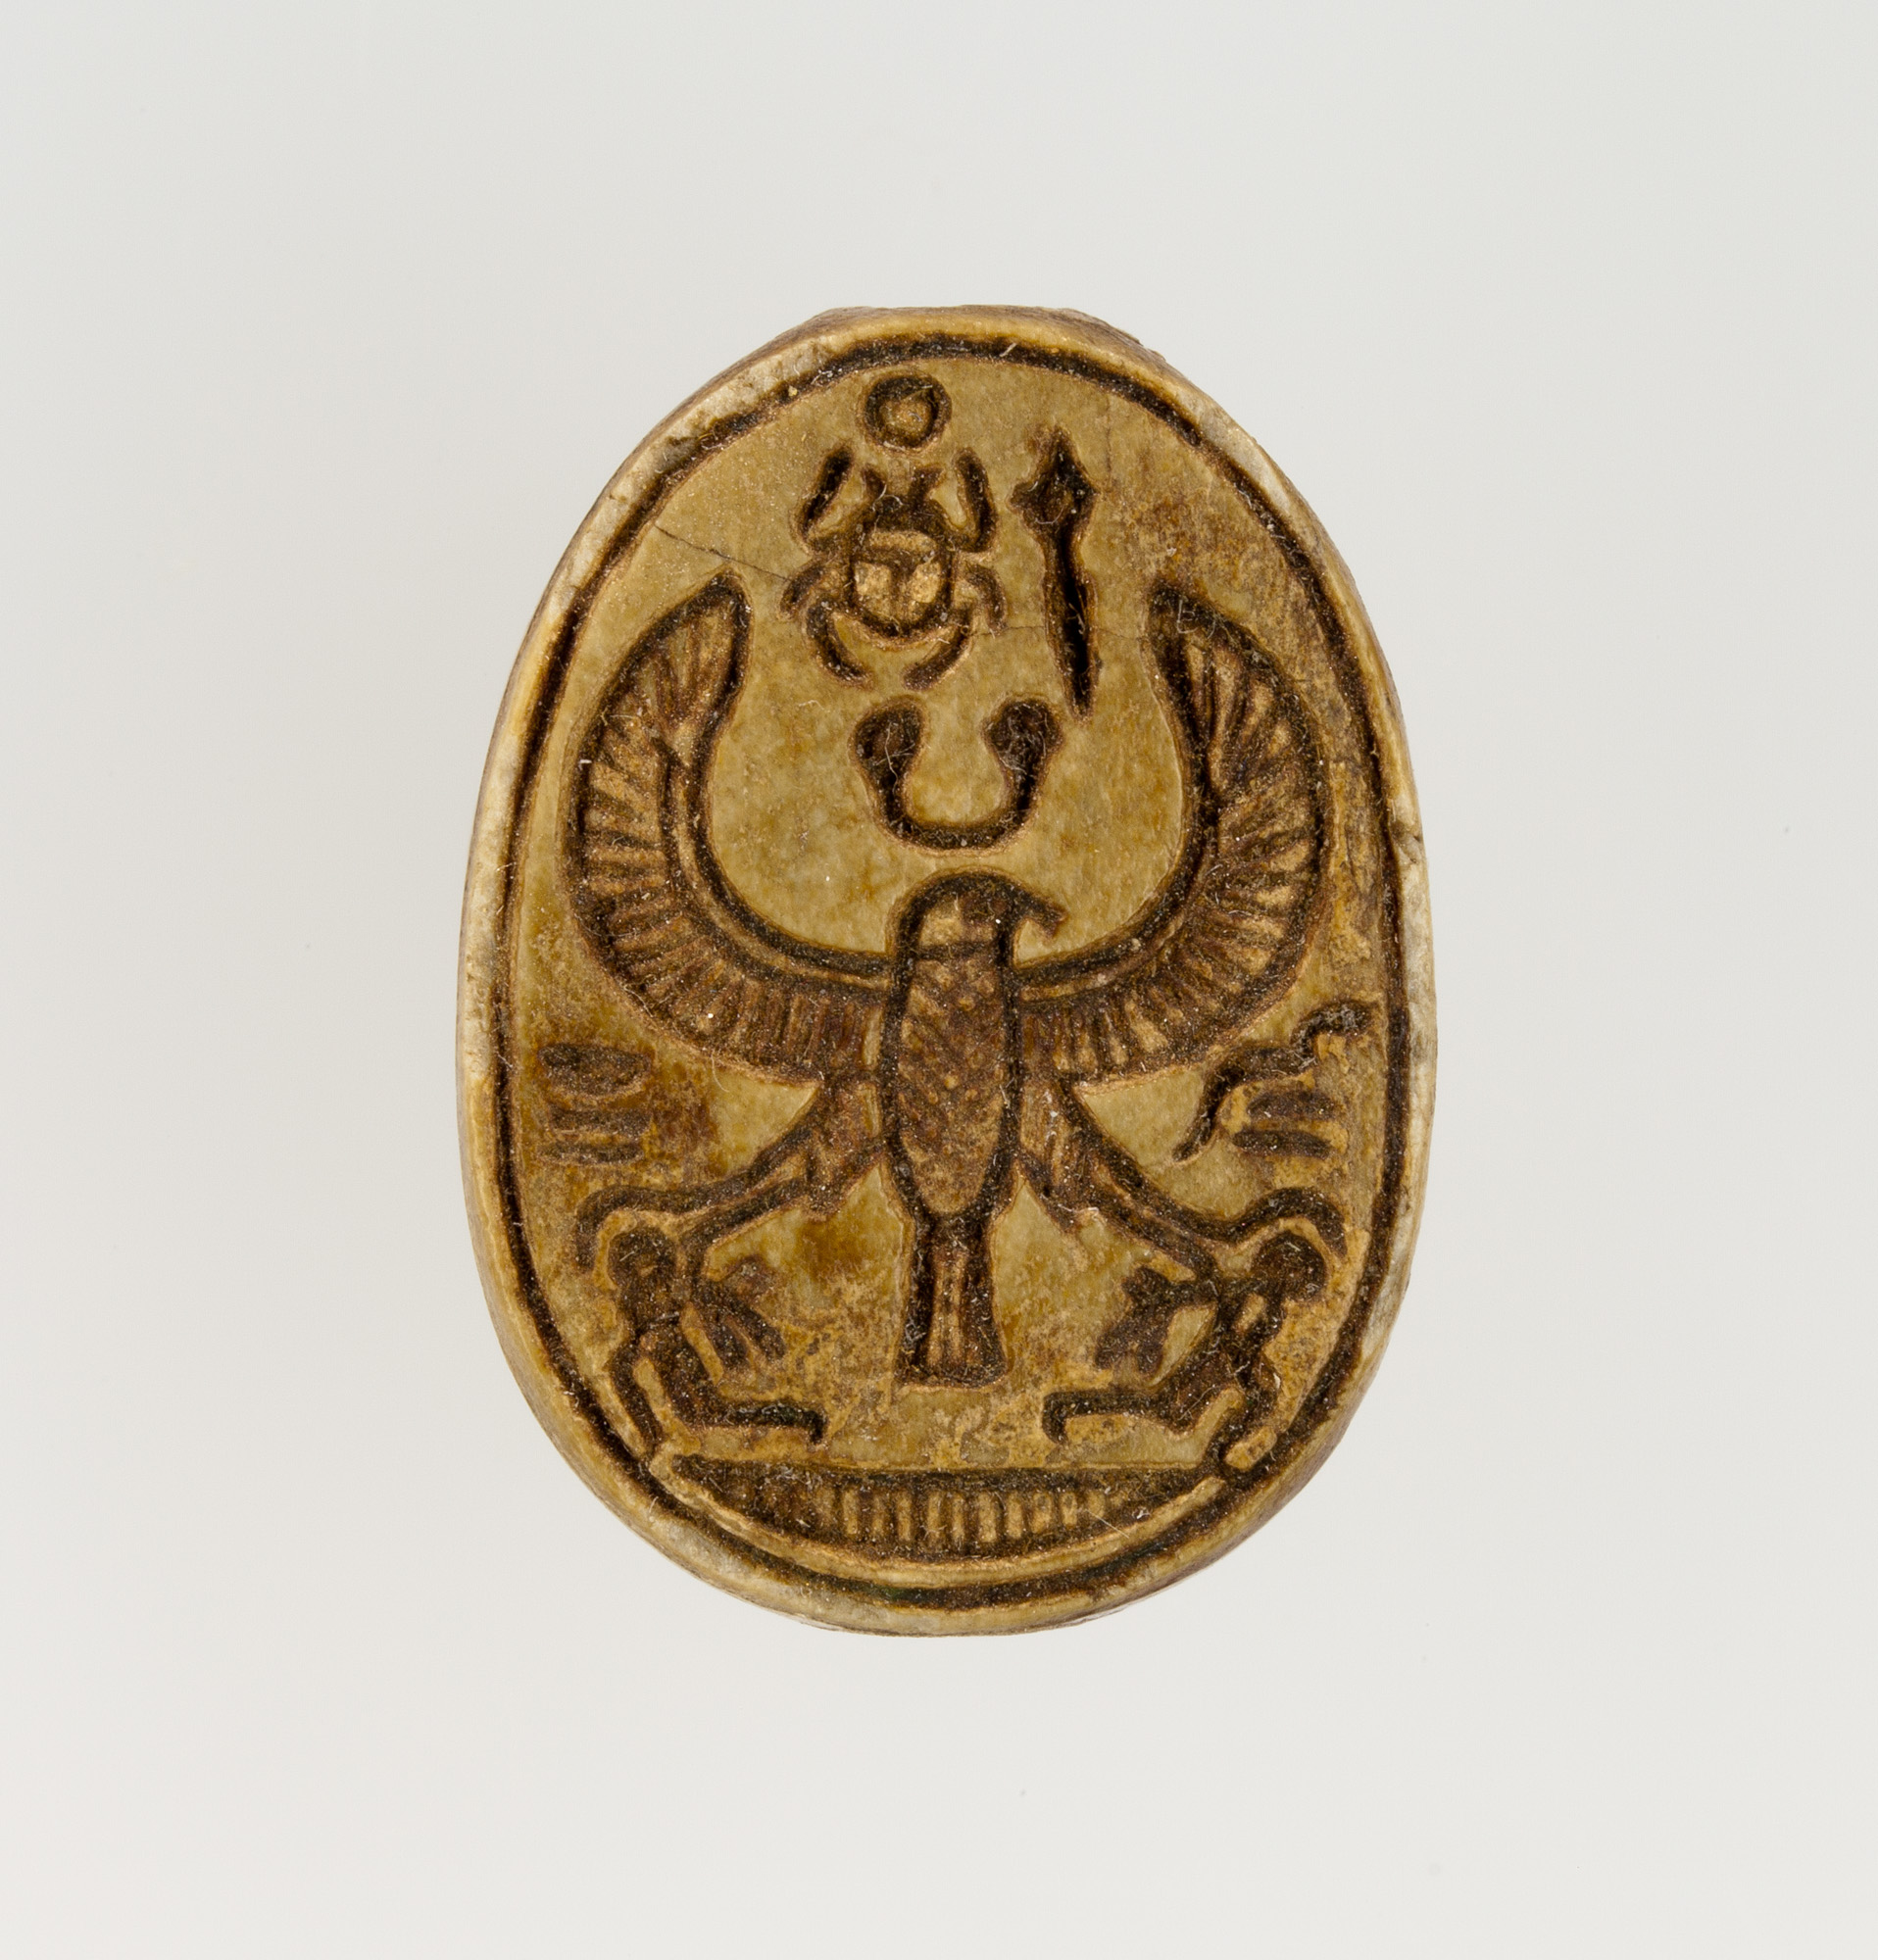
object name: scarab, thutmose i, aakheperkare, falcon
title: Scarab Inscribed with the Throne Name of Thutmose I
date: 1504-1492 BCE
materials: stone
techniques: glazing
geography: egypt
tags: hieroglyphs,scarabs